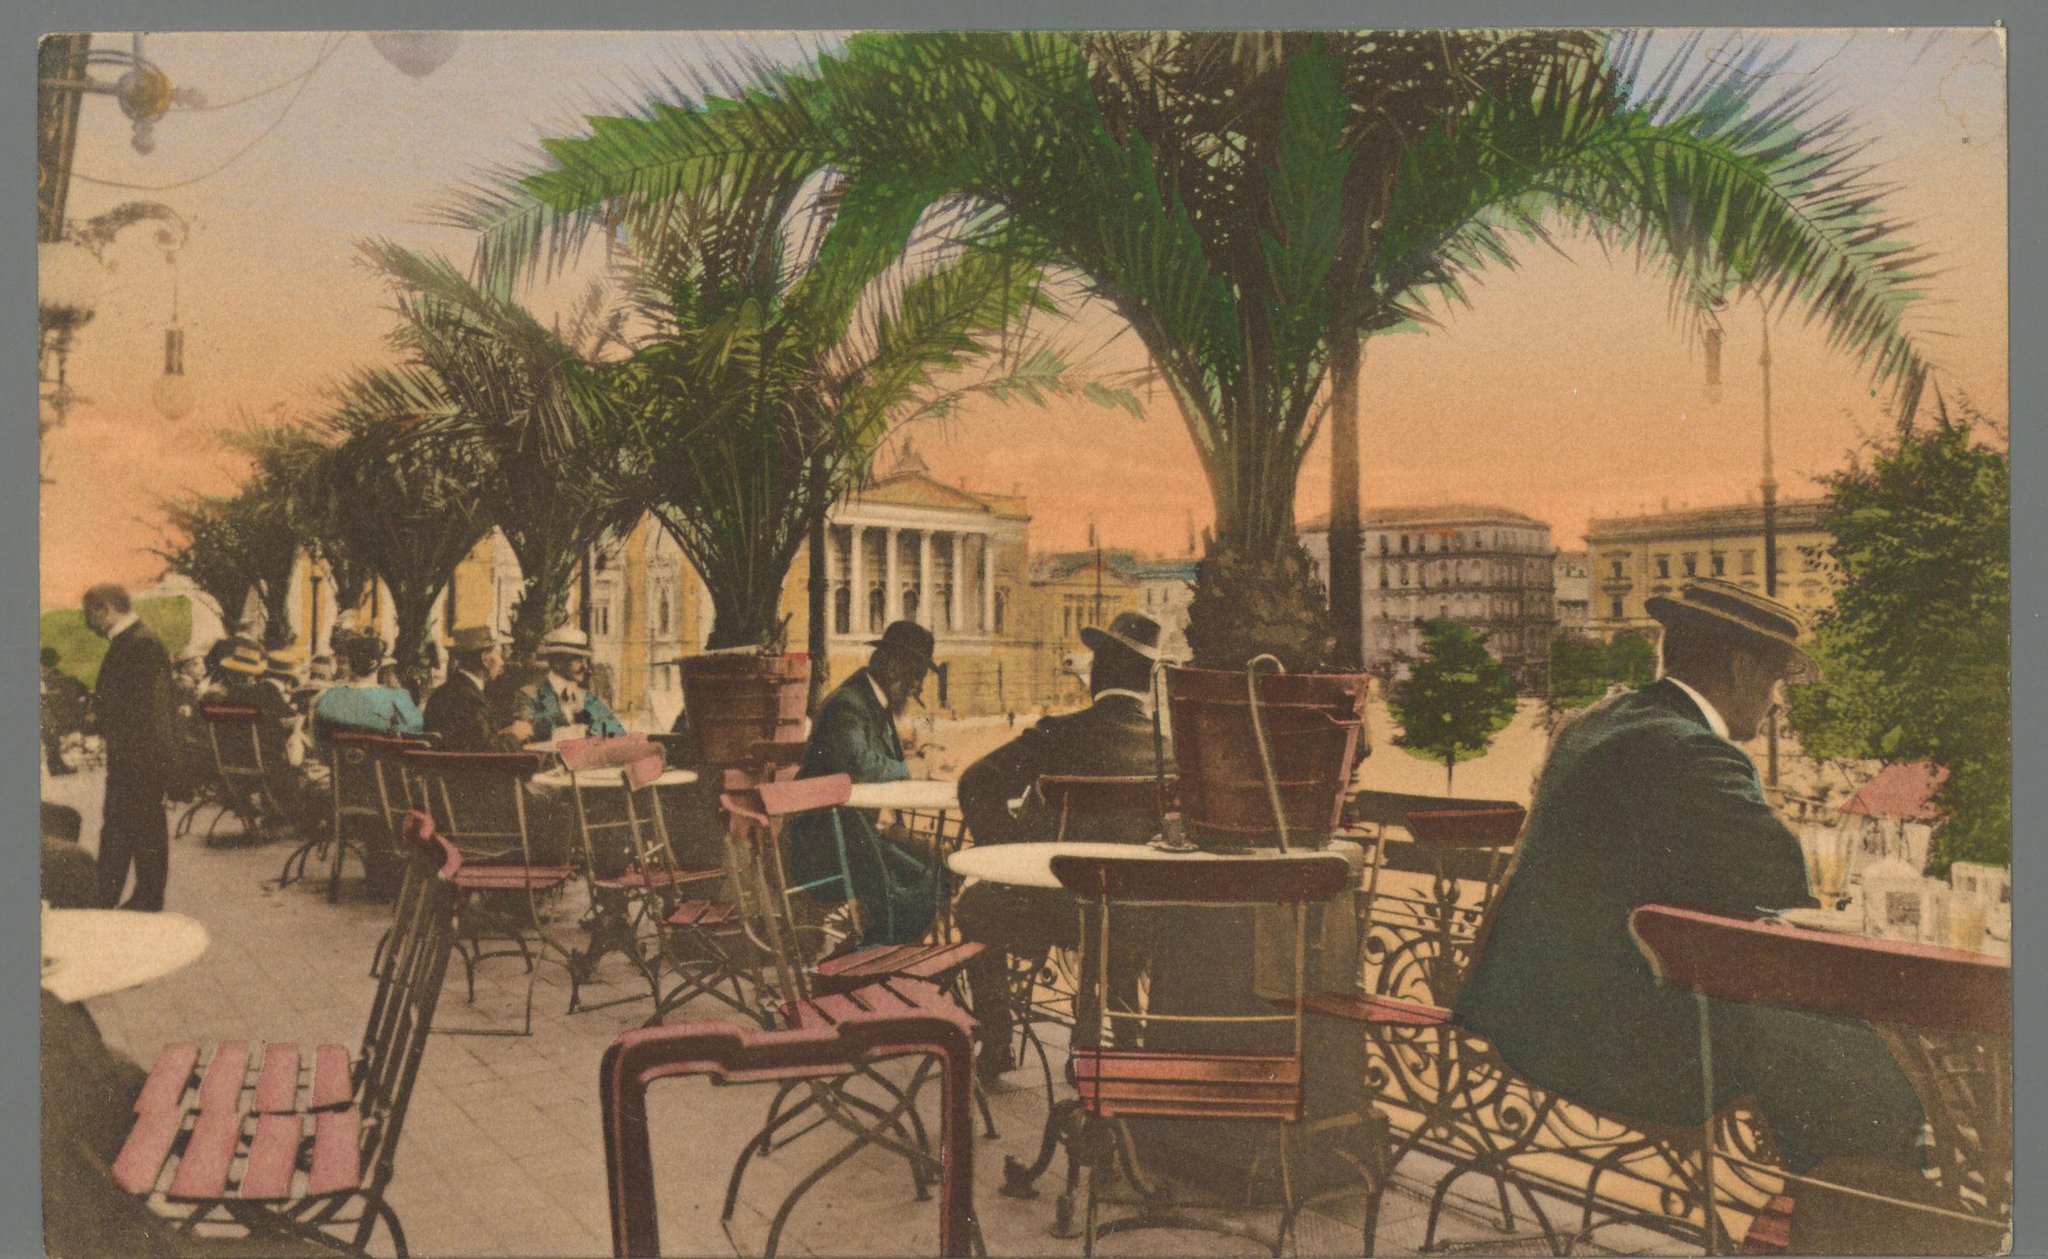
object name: ansichtkaart, prentbriefkaart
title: Leipzig. Blick vom Café Français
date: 1907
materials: cardboard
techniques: photograph, lithograph, hand coloring, writing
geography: hamburg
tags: inn, coffee-house, public house, etc.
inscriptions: date